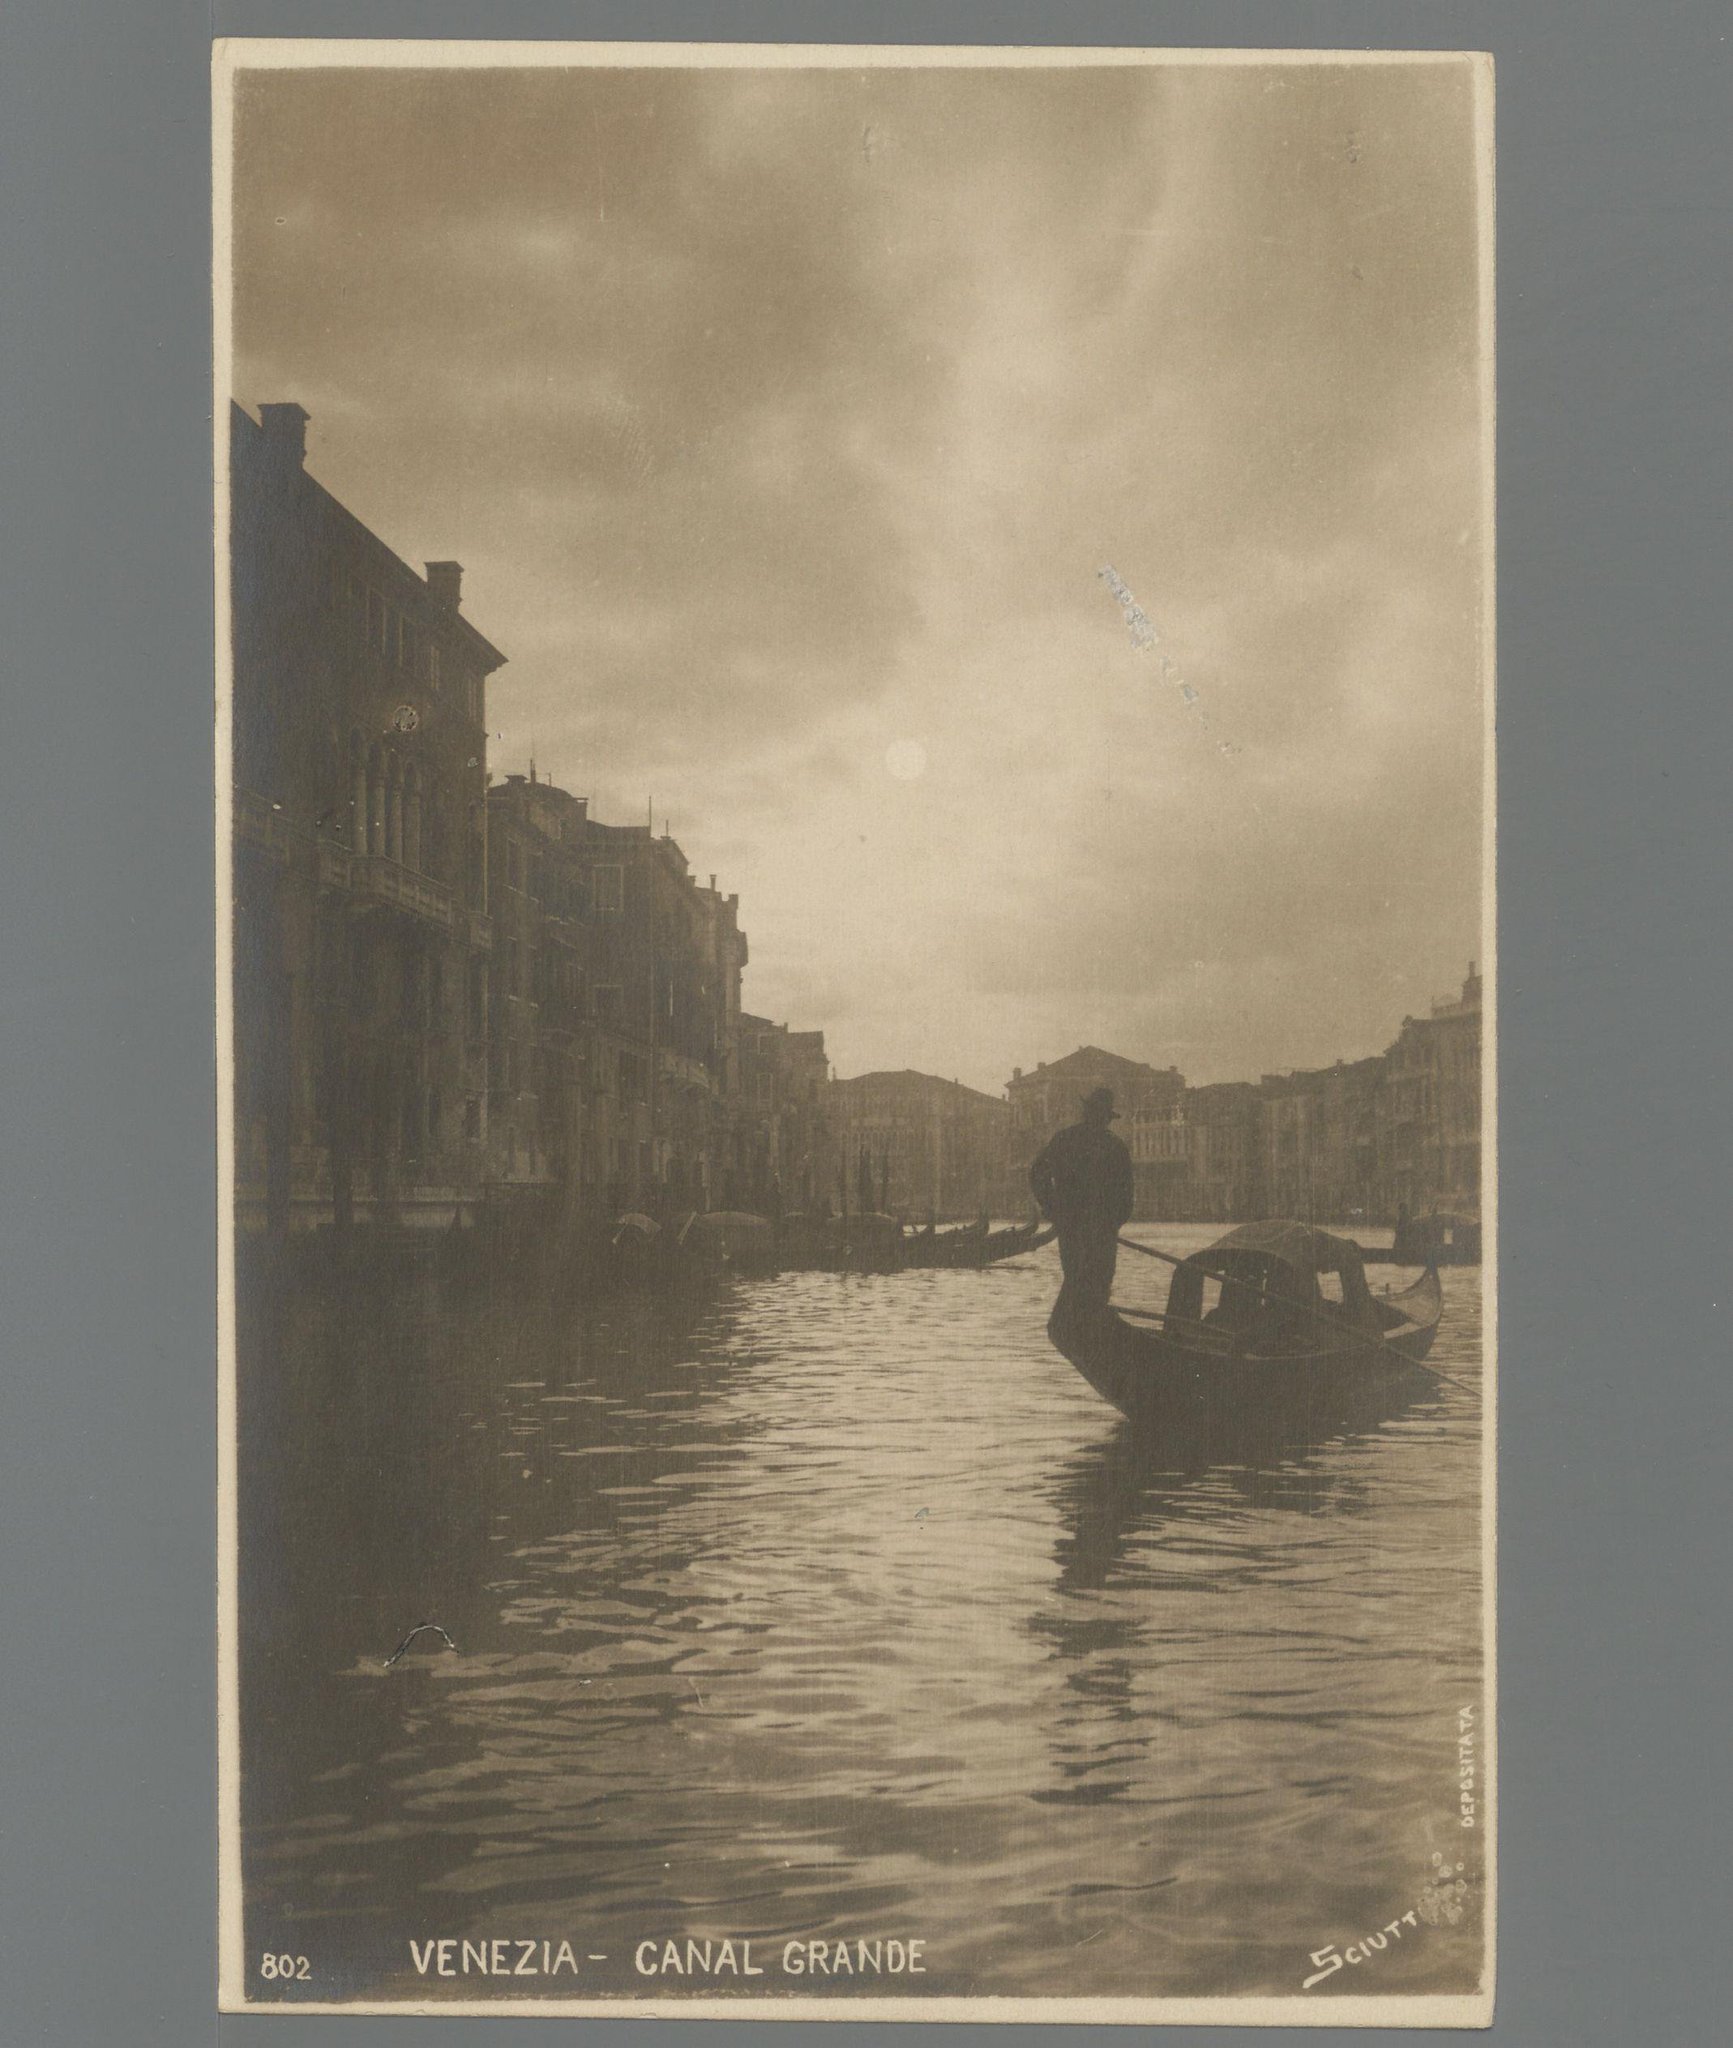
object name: photograph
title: Venezia. Canal Grande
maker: tensi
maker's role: publisher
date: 1906-1920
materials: photographic support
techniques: photography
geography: italy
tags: canal, gondola, city-view, and landscape with man-made constructions (+ city(-scape) with figures, staffage)